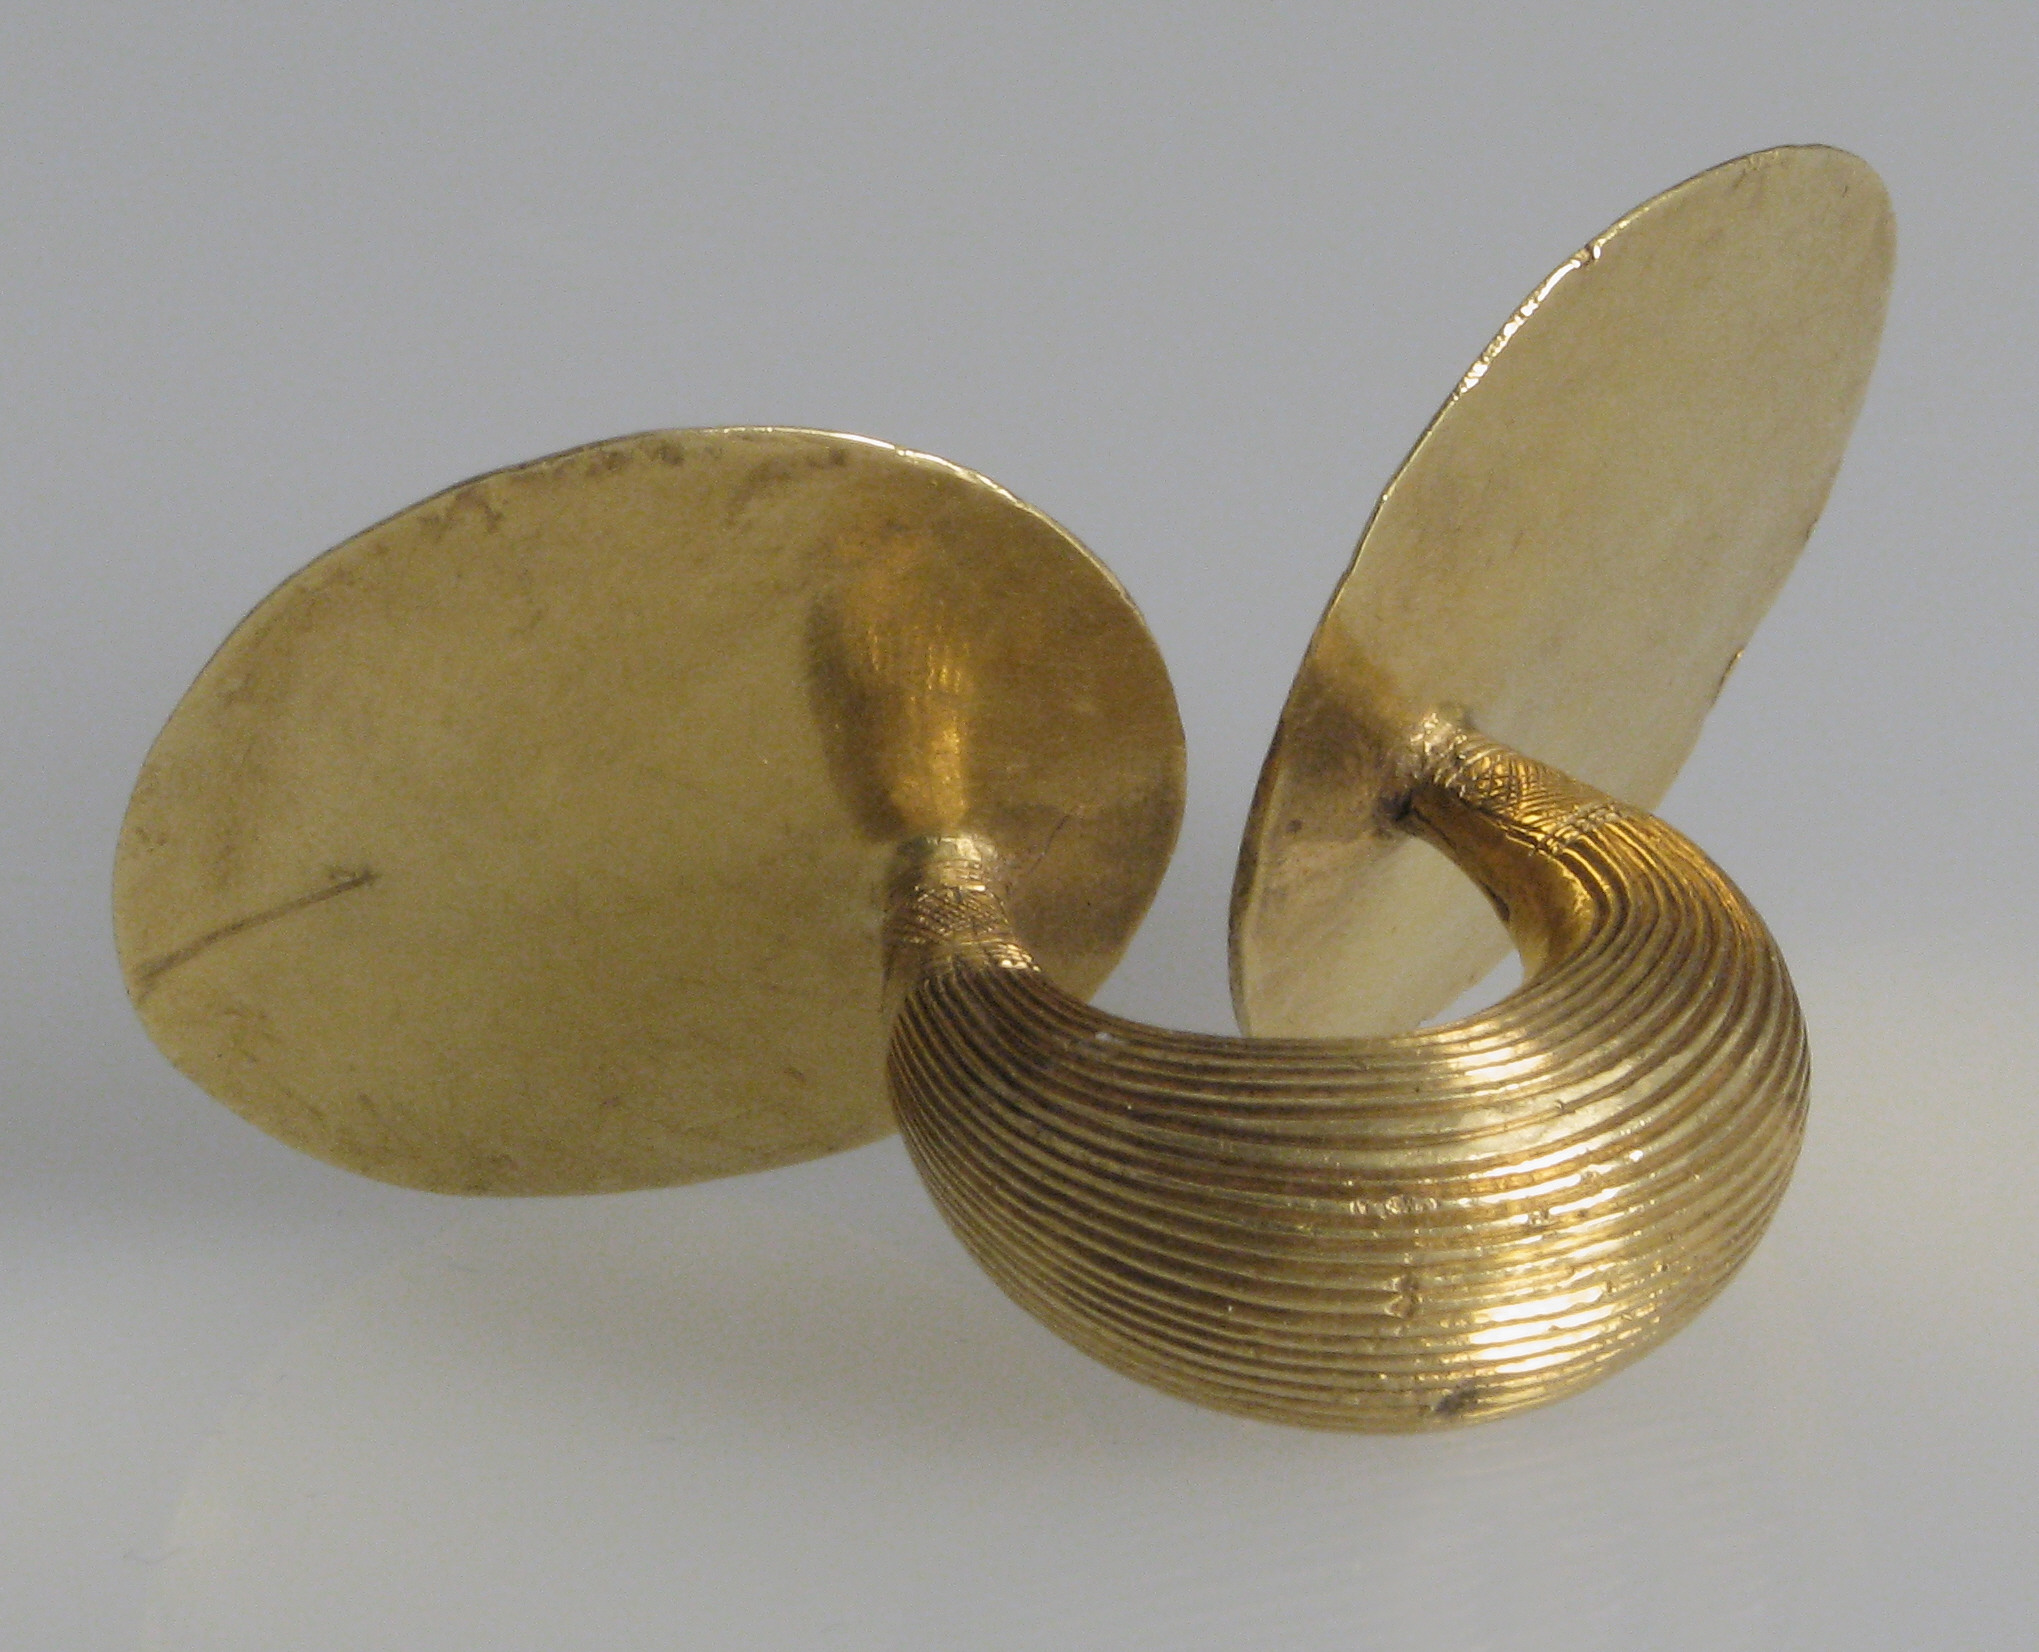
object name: ornament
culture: irish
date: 800 BCE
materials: gold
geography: ireland